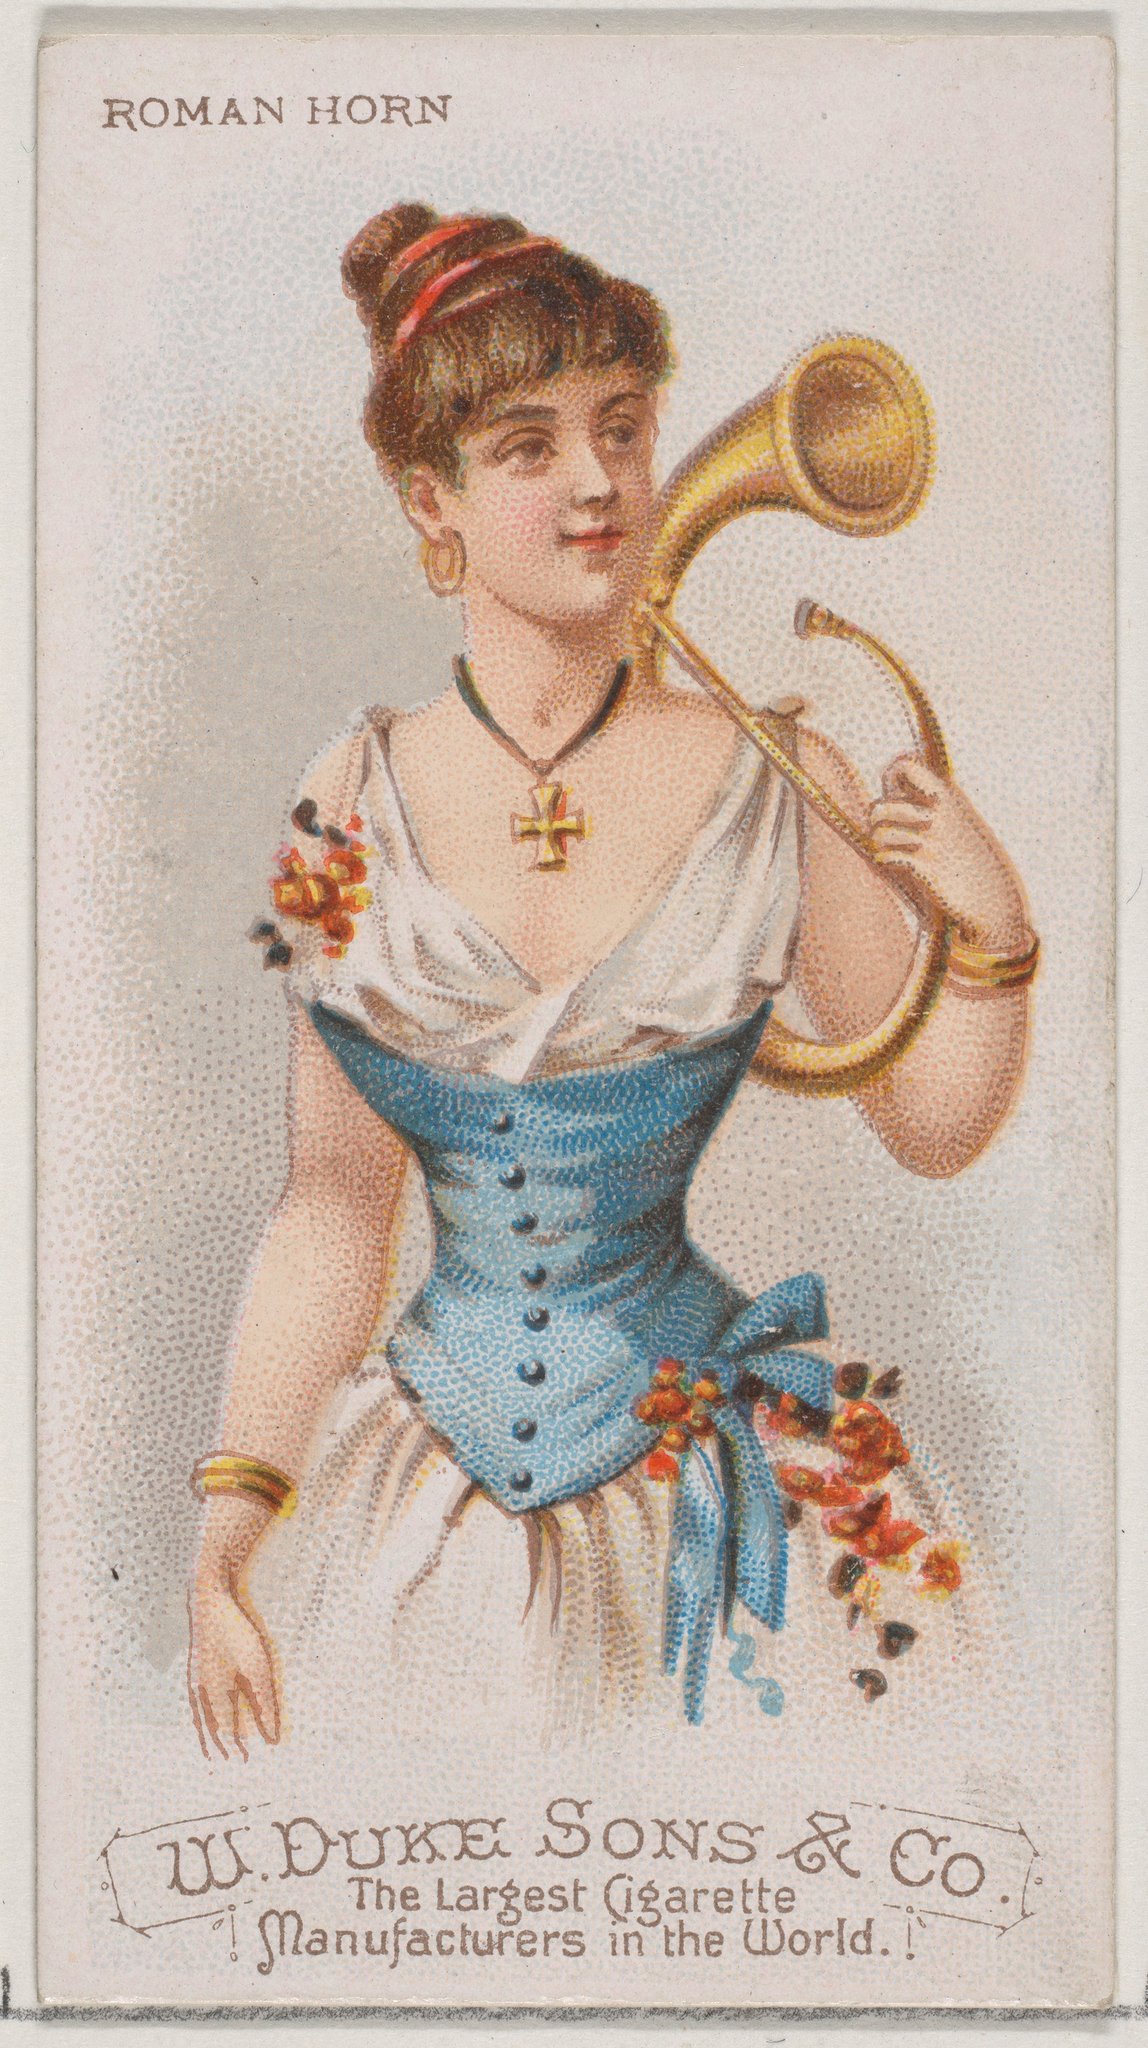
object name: print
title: Roman Horn, from the Musical Instruments series (N82) for Duke brand cigarettes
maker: w. duke, sons & co.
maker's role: publisher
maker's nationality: american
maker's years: 1870-1920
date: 1888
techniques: color lithograph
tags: musical instruments,women,musicians